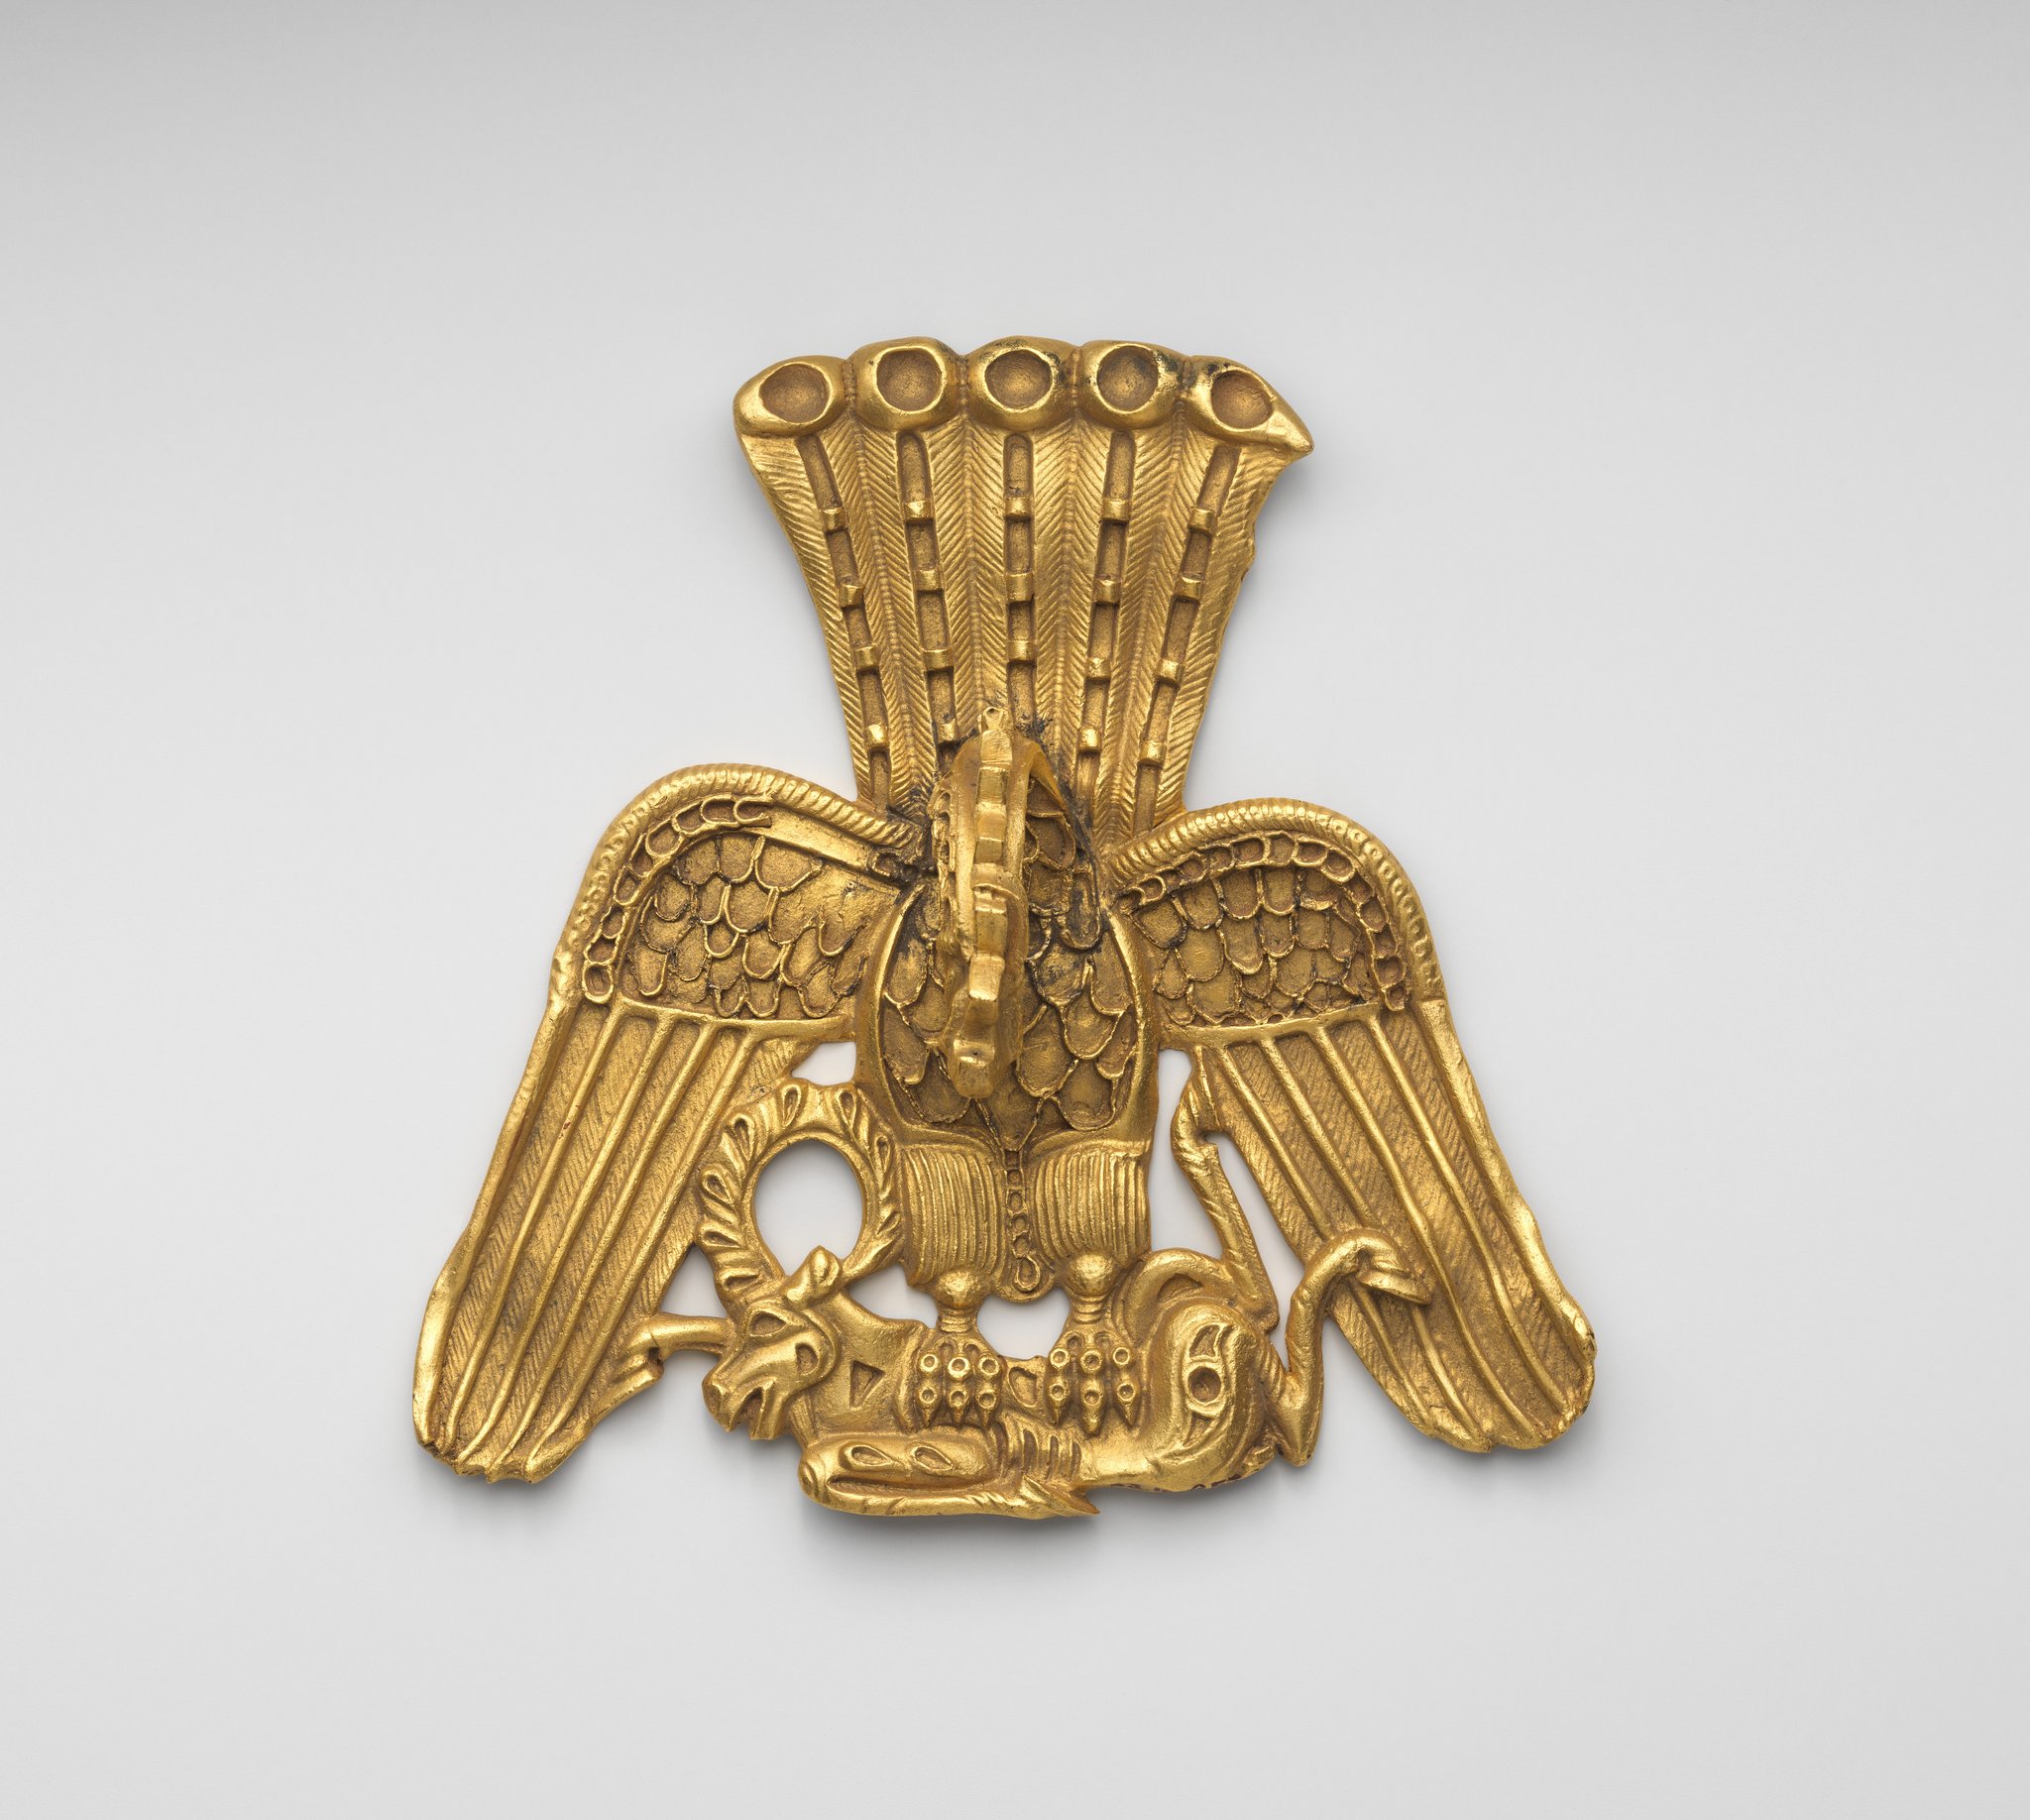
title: Reproduction of a Scythian plaque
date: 1801-1900